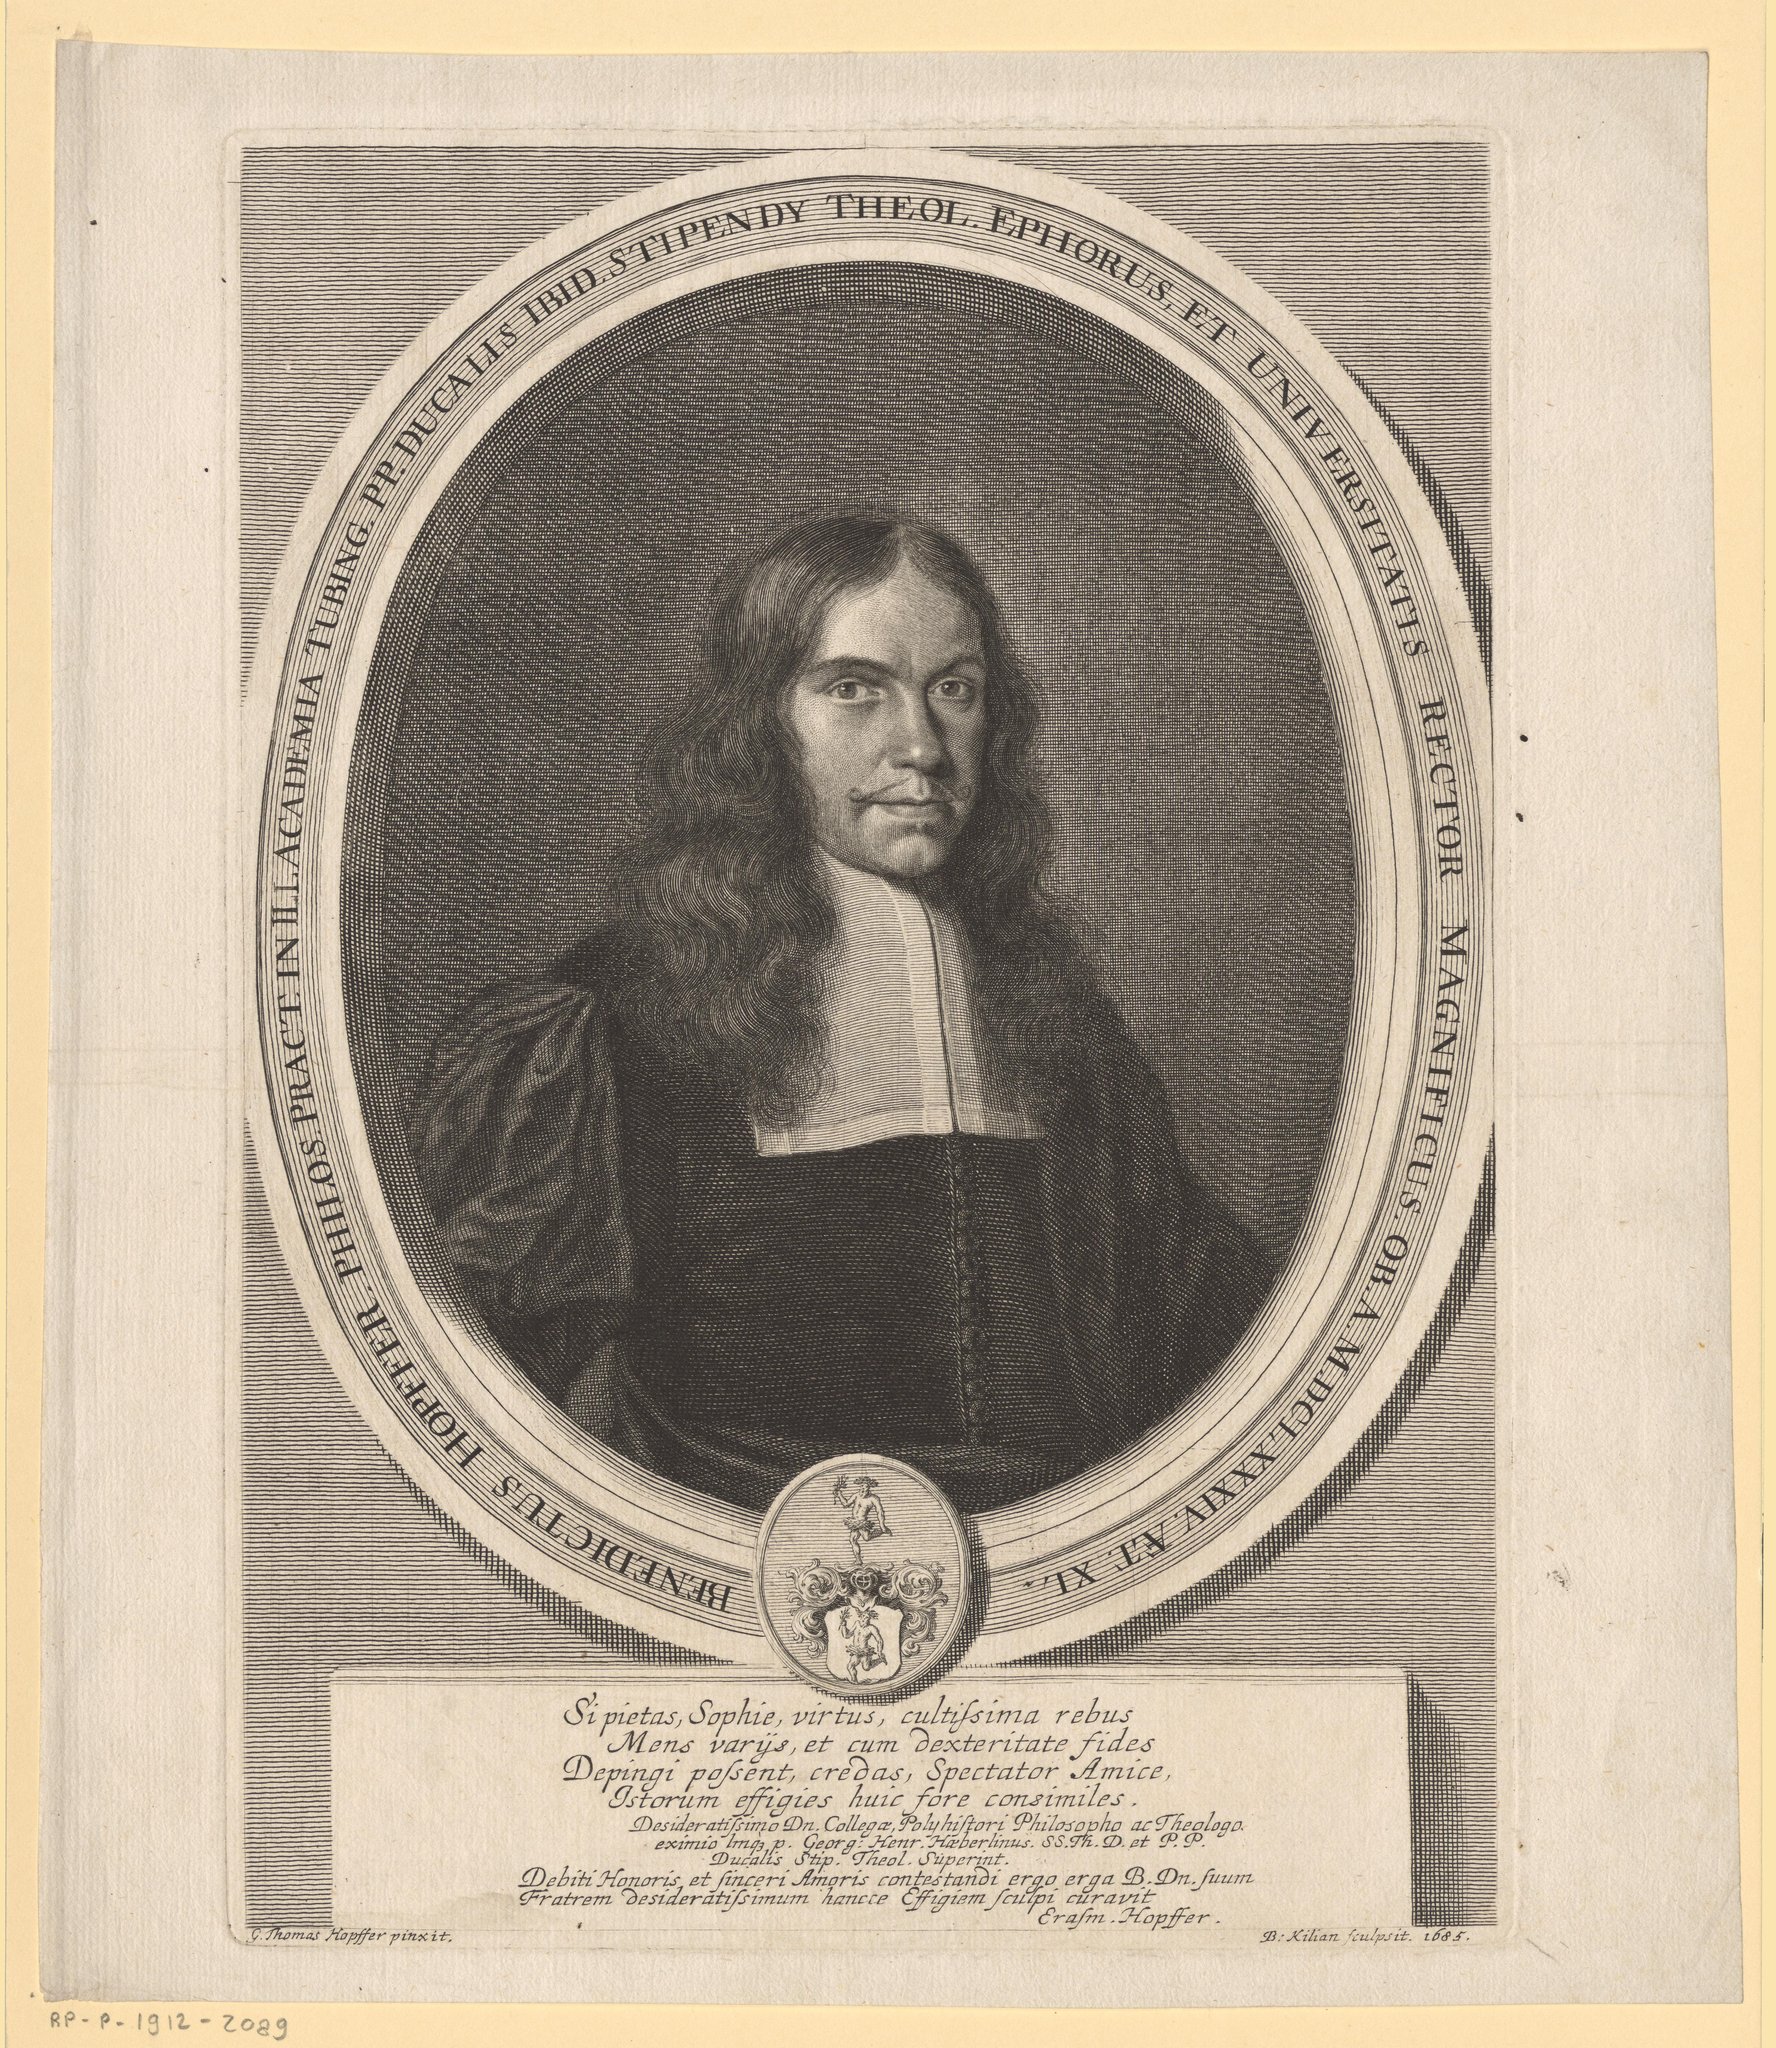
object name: print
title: Portret van Benedikt Hopffer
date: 1685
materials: paper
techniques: engraving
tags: theologian, historical persons, armorial bearing, heraldry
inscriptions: date